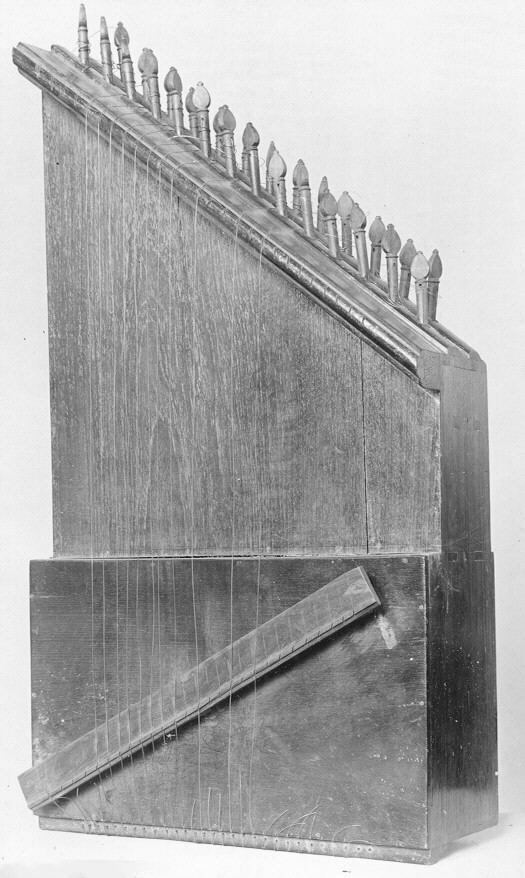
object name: kanuna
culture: thai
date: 1867-1900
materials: wood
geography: india